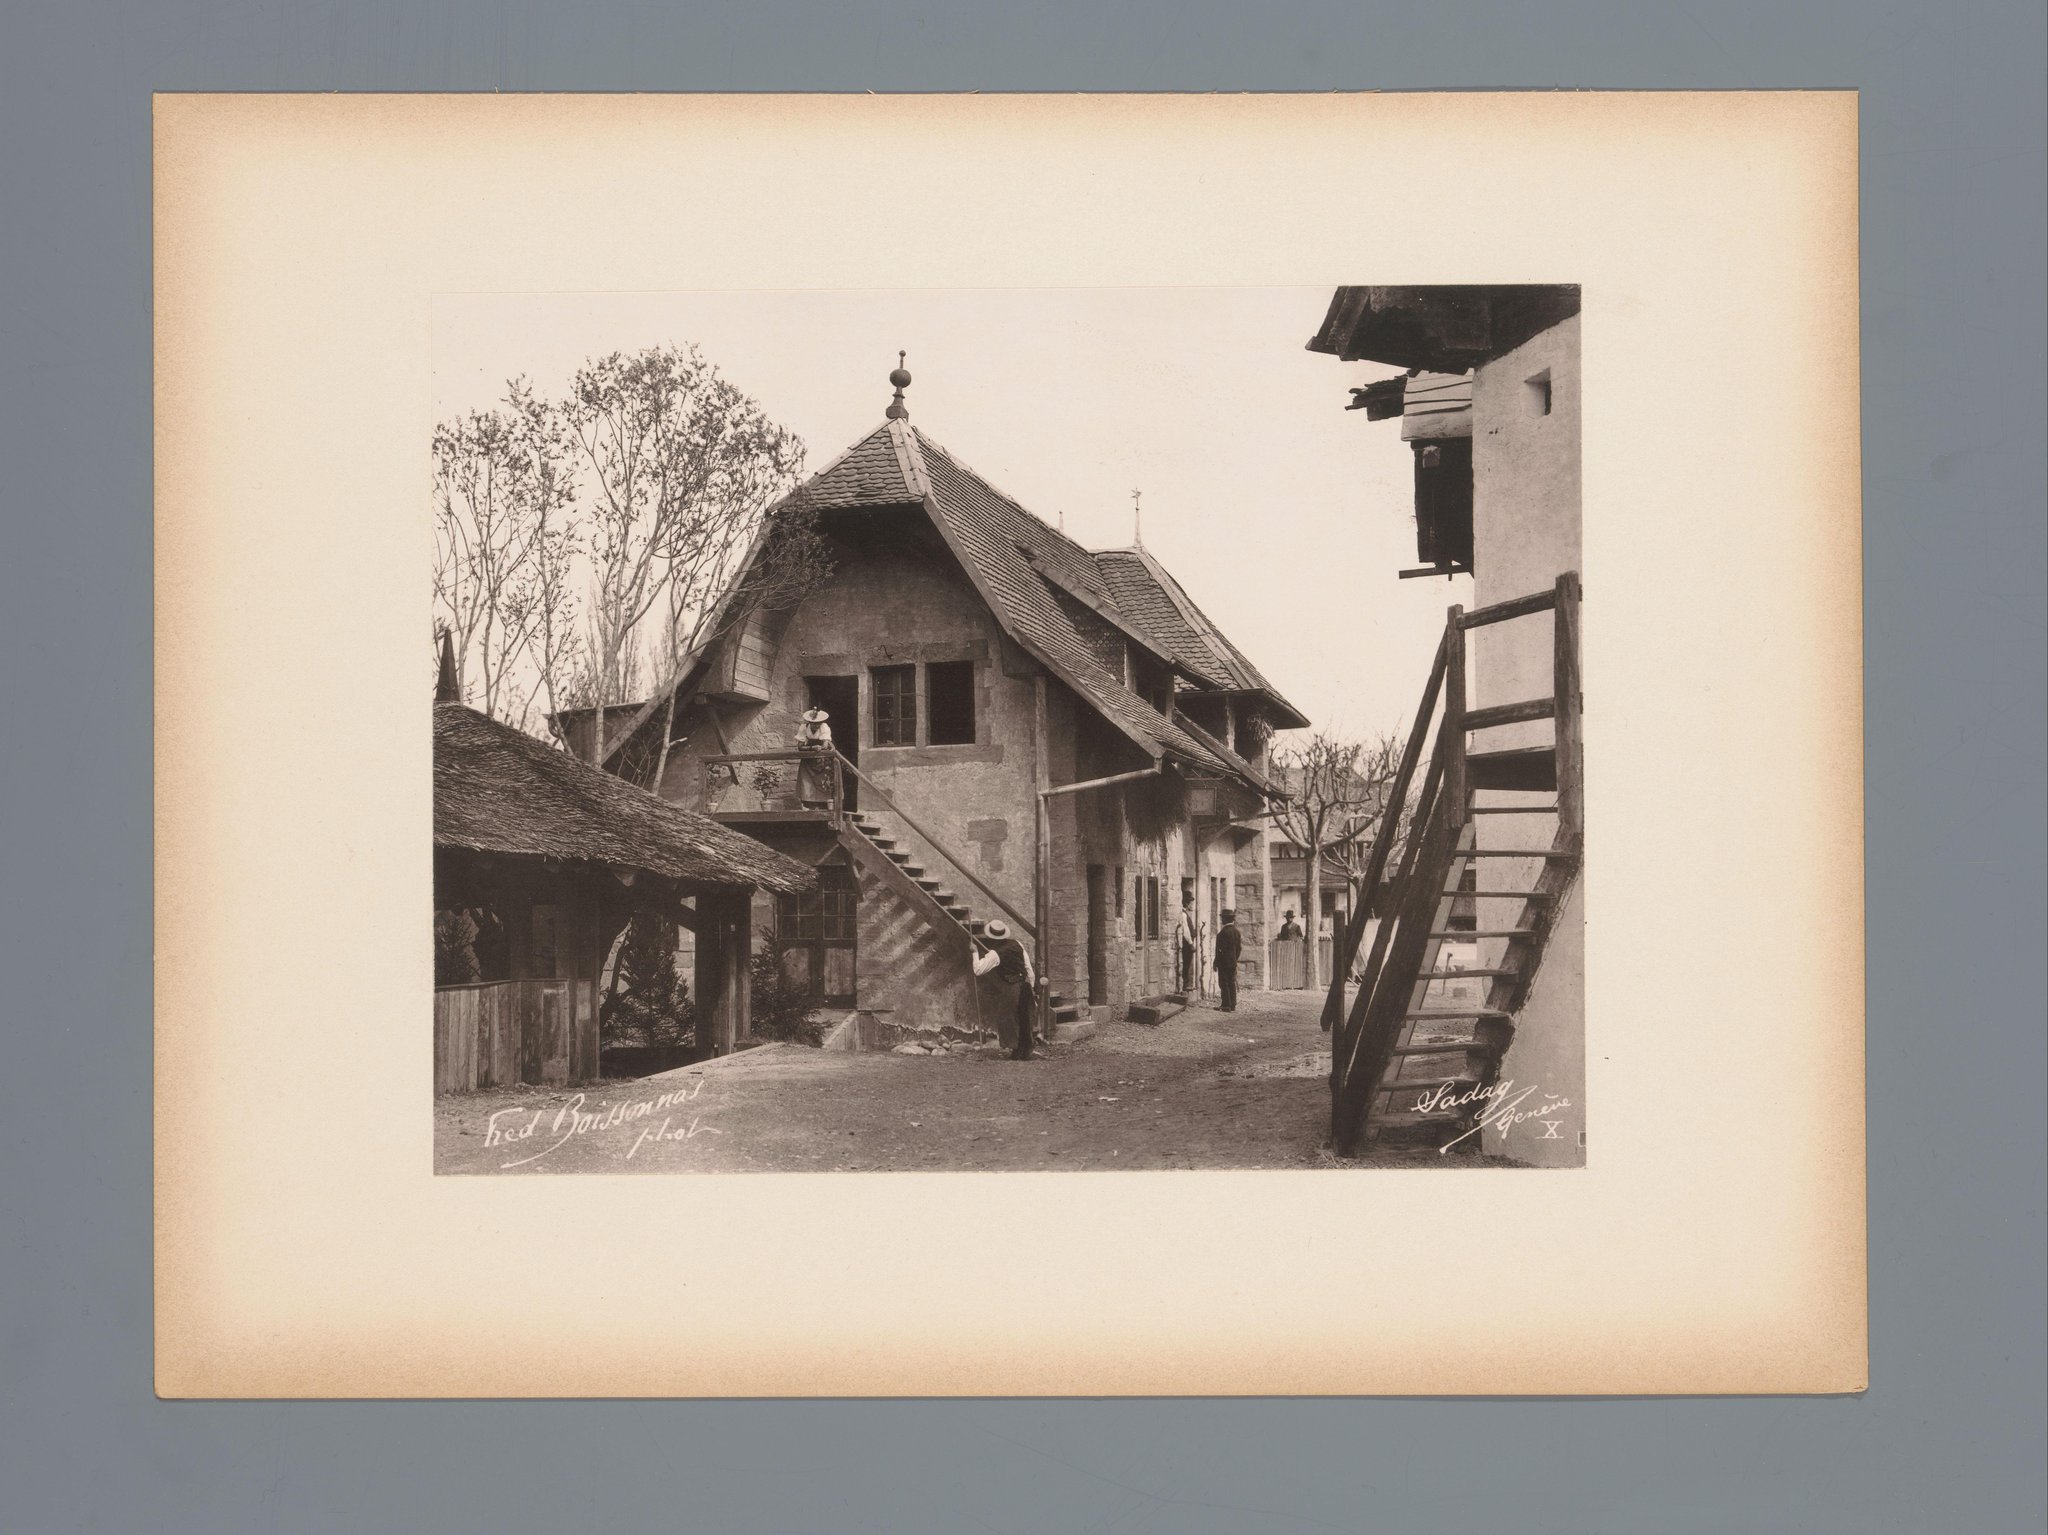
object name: page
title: Straatgezicht in een Zwitsers dorp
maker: frédéric boissonnas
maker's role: fotograaf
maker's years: 1858-1946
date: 1891-1896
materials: paper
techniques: photograph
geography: geneva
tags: street (+ city(-scape) with figures, staffage), switzerland